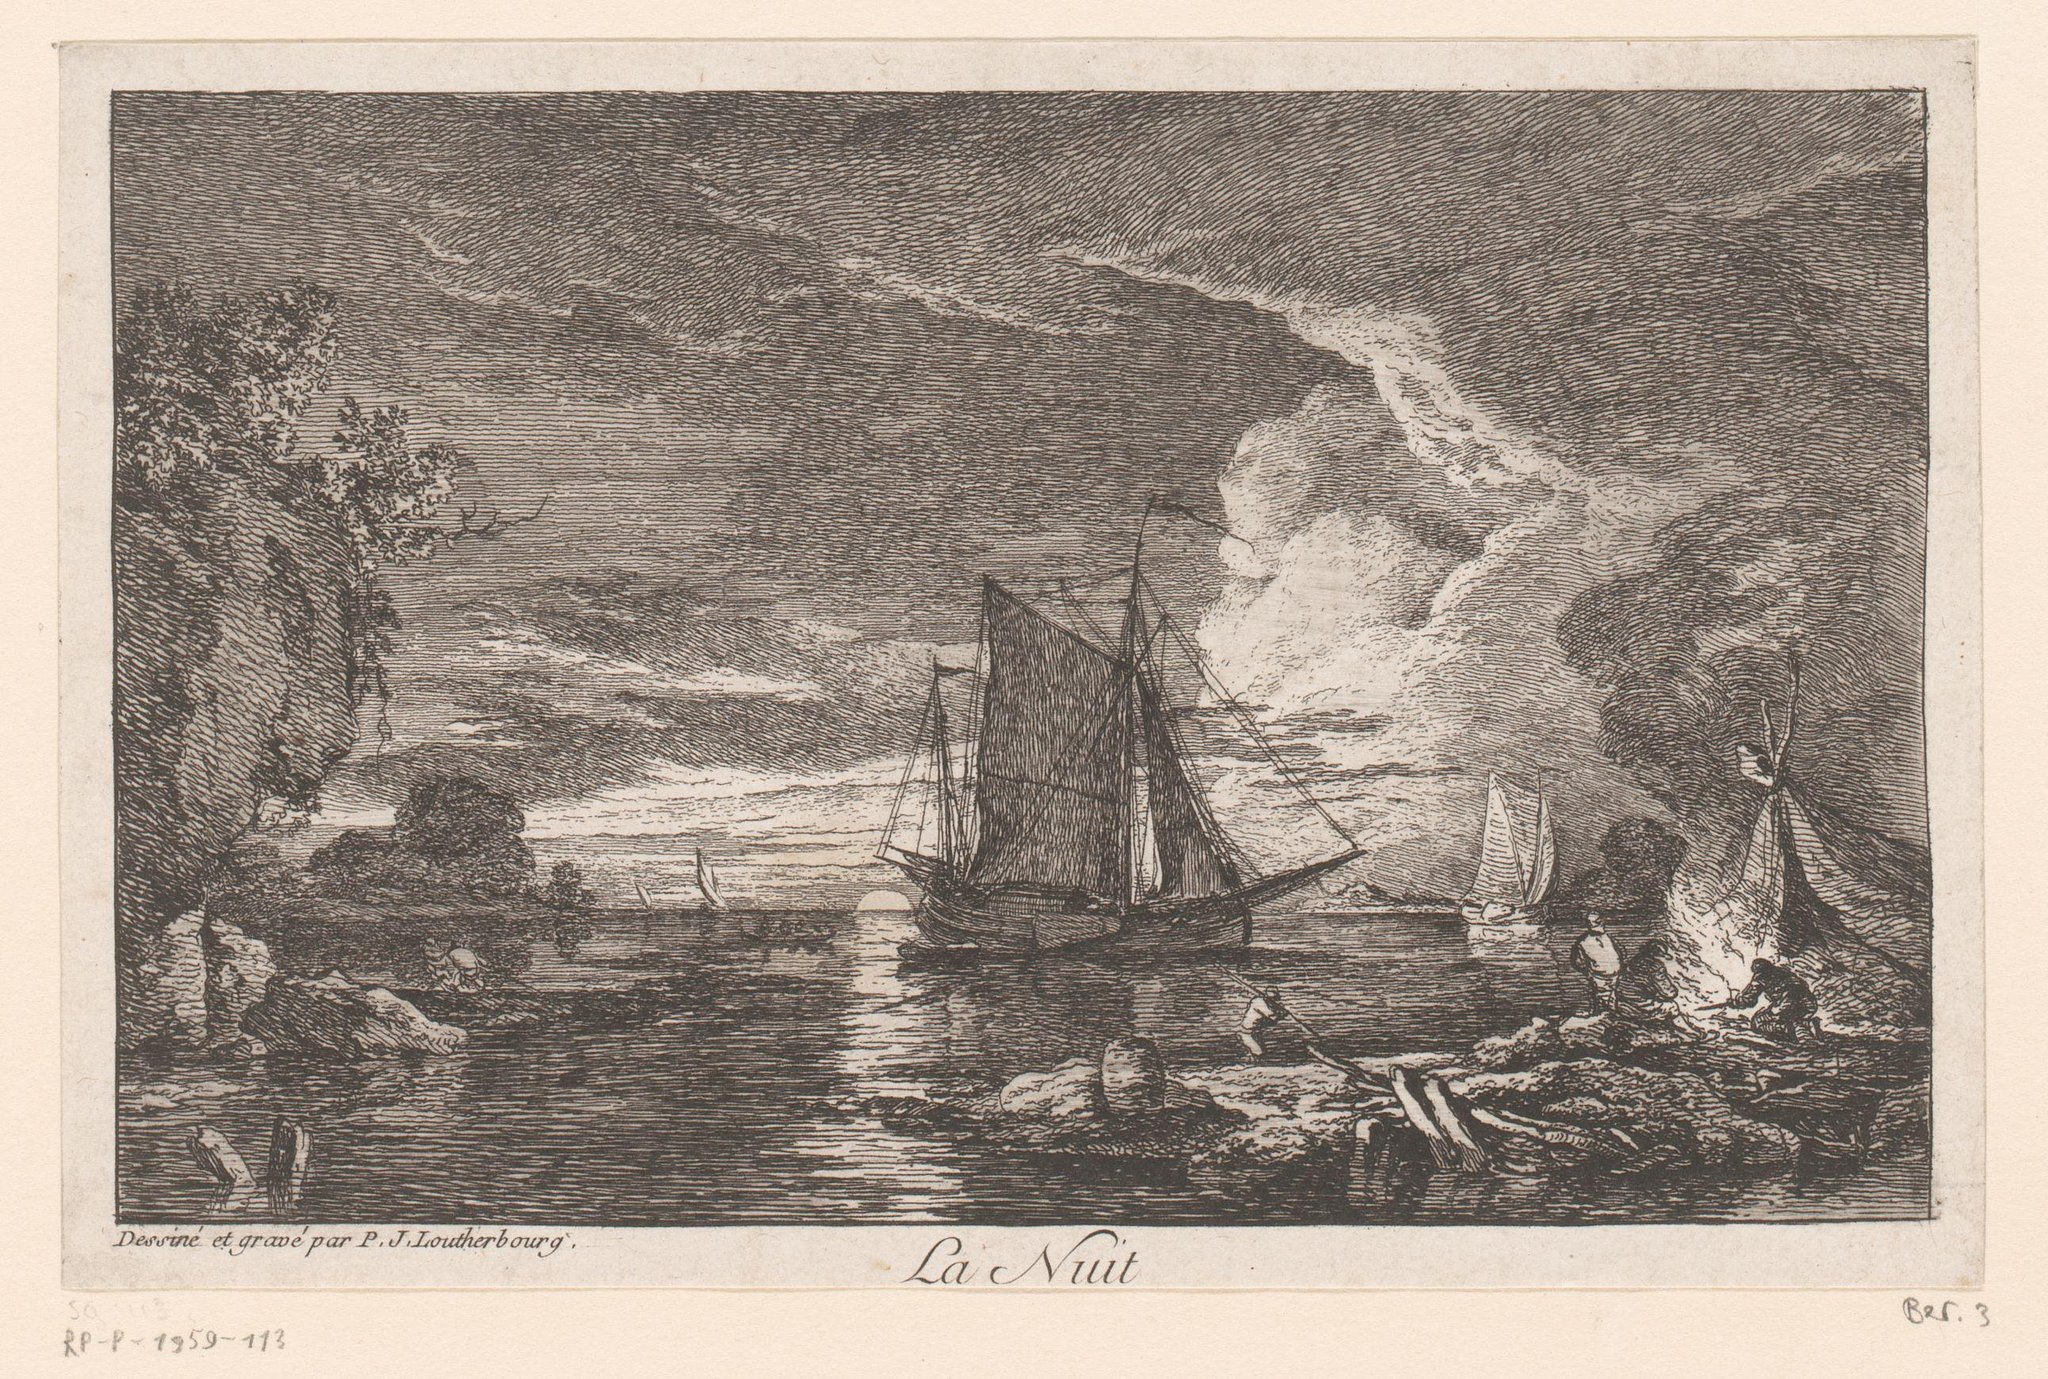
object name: print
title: Nachtelijk zeegezicht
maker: philipp jacques loutherbourg (i)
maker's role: draughtsman, print maker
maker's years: 1698-1768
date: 1708-1812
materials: paper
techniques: etching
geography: paris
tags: landscapes with waters, waterscapes, seascapes (in the temperate zone), night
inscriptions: collector's mark: Lugt 2228, collector's mark: Lugt 2760